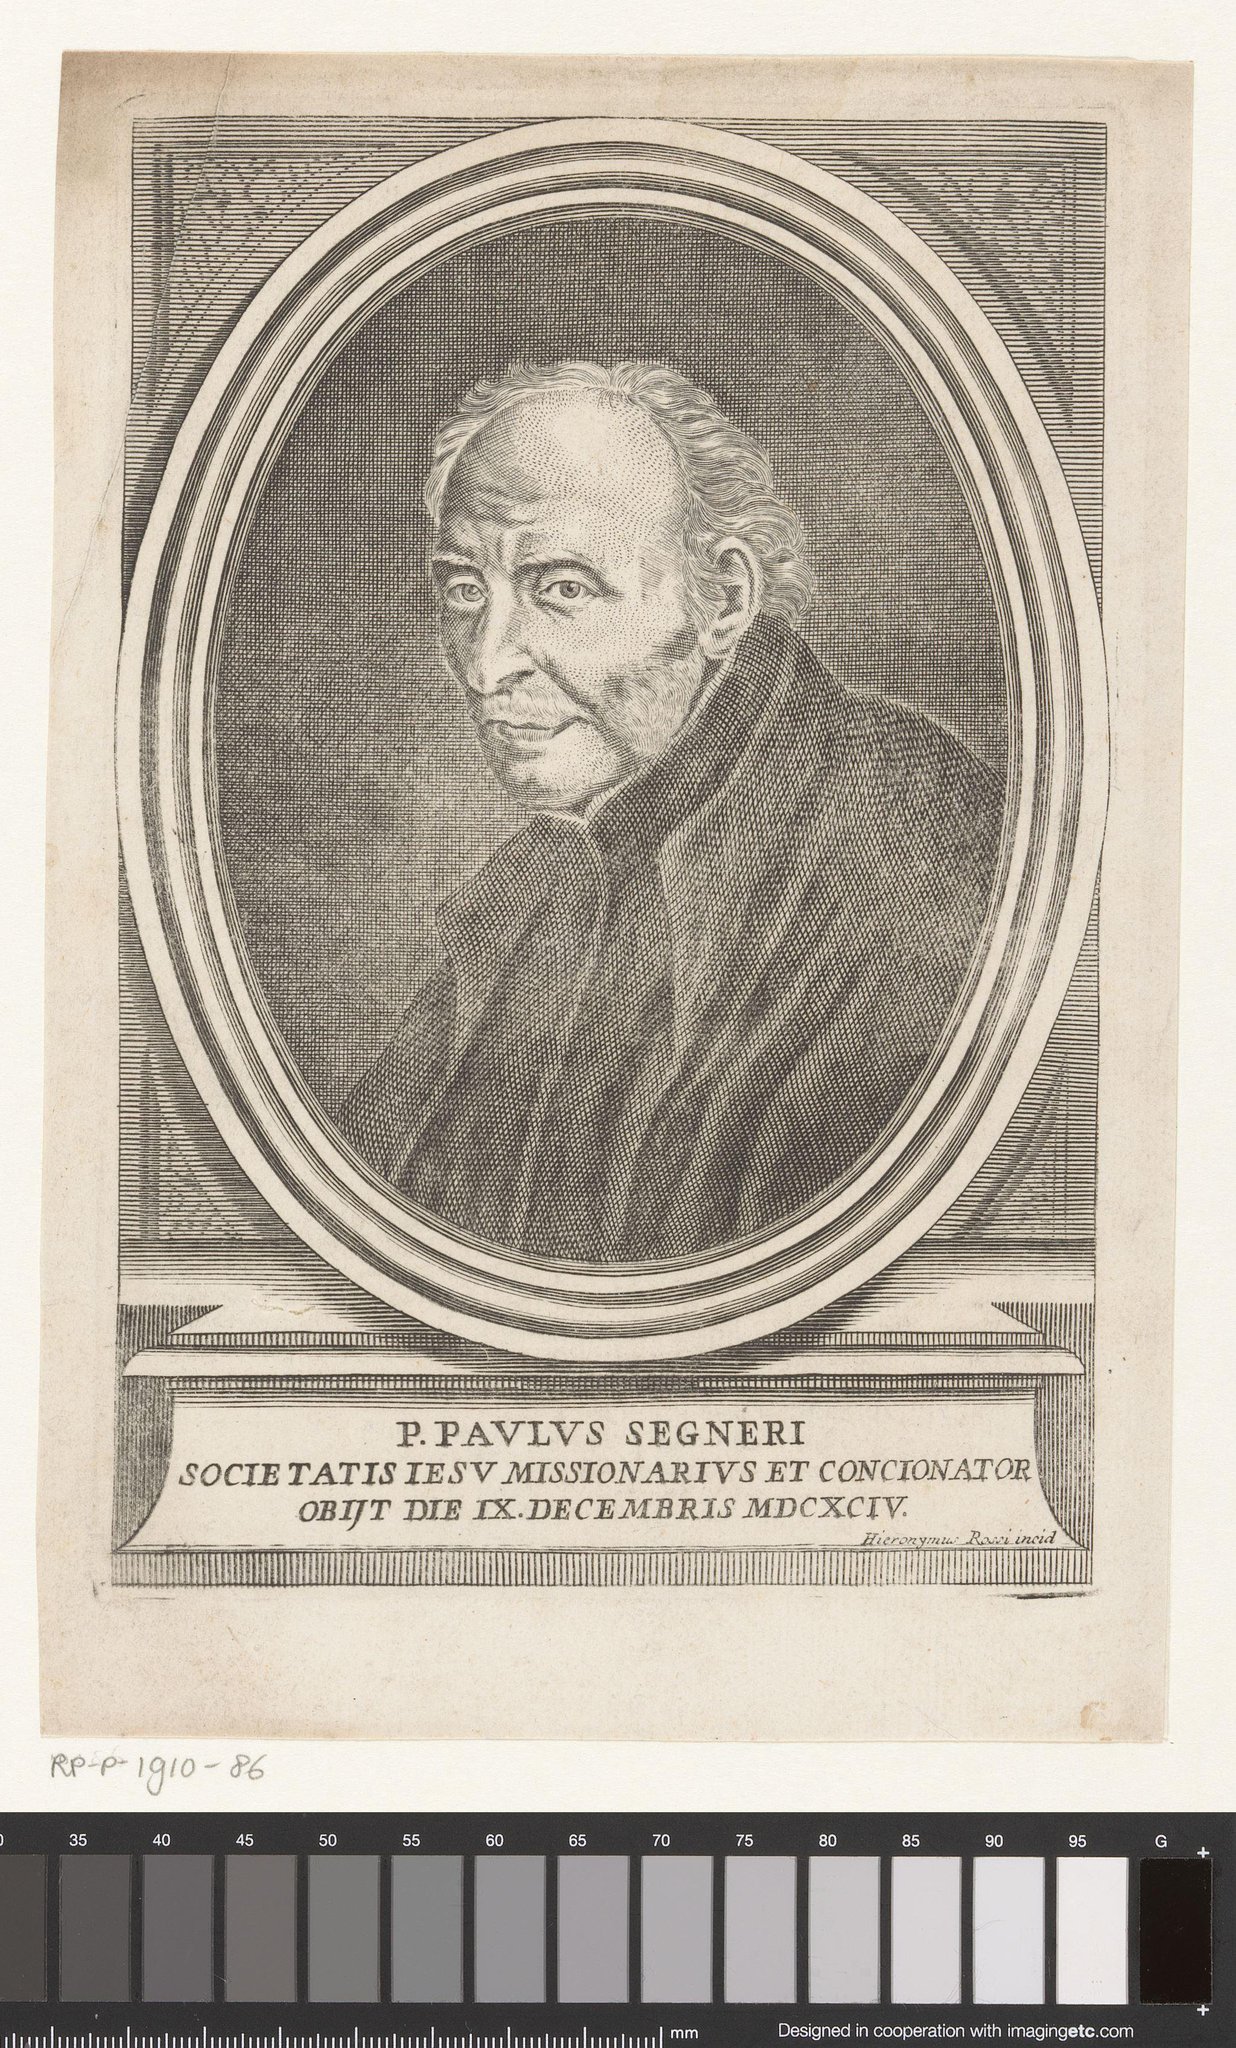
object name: print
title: Portret van missionaris en schrijver Paolo Segneri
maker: girolamo rossi (ii)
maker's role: print maker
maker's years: 1682-1762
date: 1692-1762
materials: paper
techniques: engraving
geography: rome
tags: missionary, historical persons, portrait of a writer, writer, poet, author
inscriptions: collector's mark: Lugt 2228